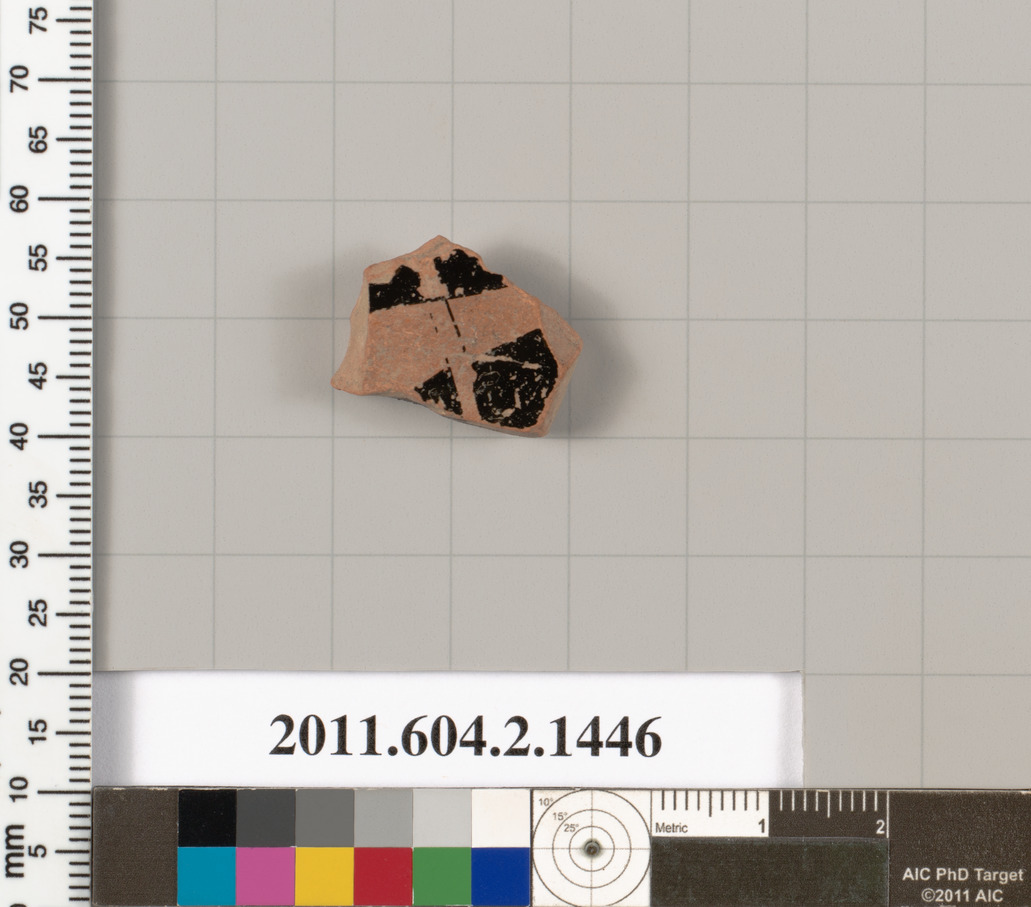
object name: skyphos fragment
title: Terracotta fragment of a skyphos (deep drinking cup)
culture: greek, attic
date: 475-451 BCE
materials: terracotta